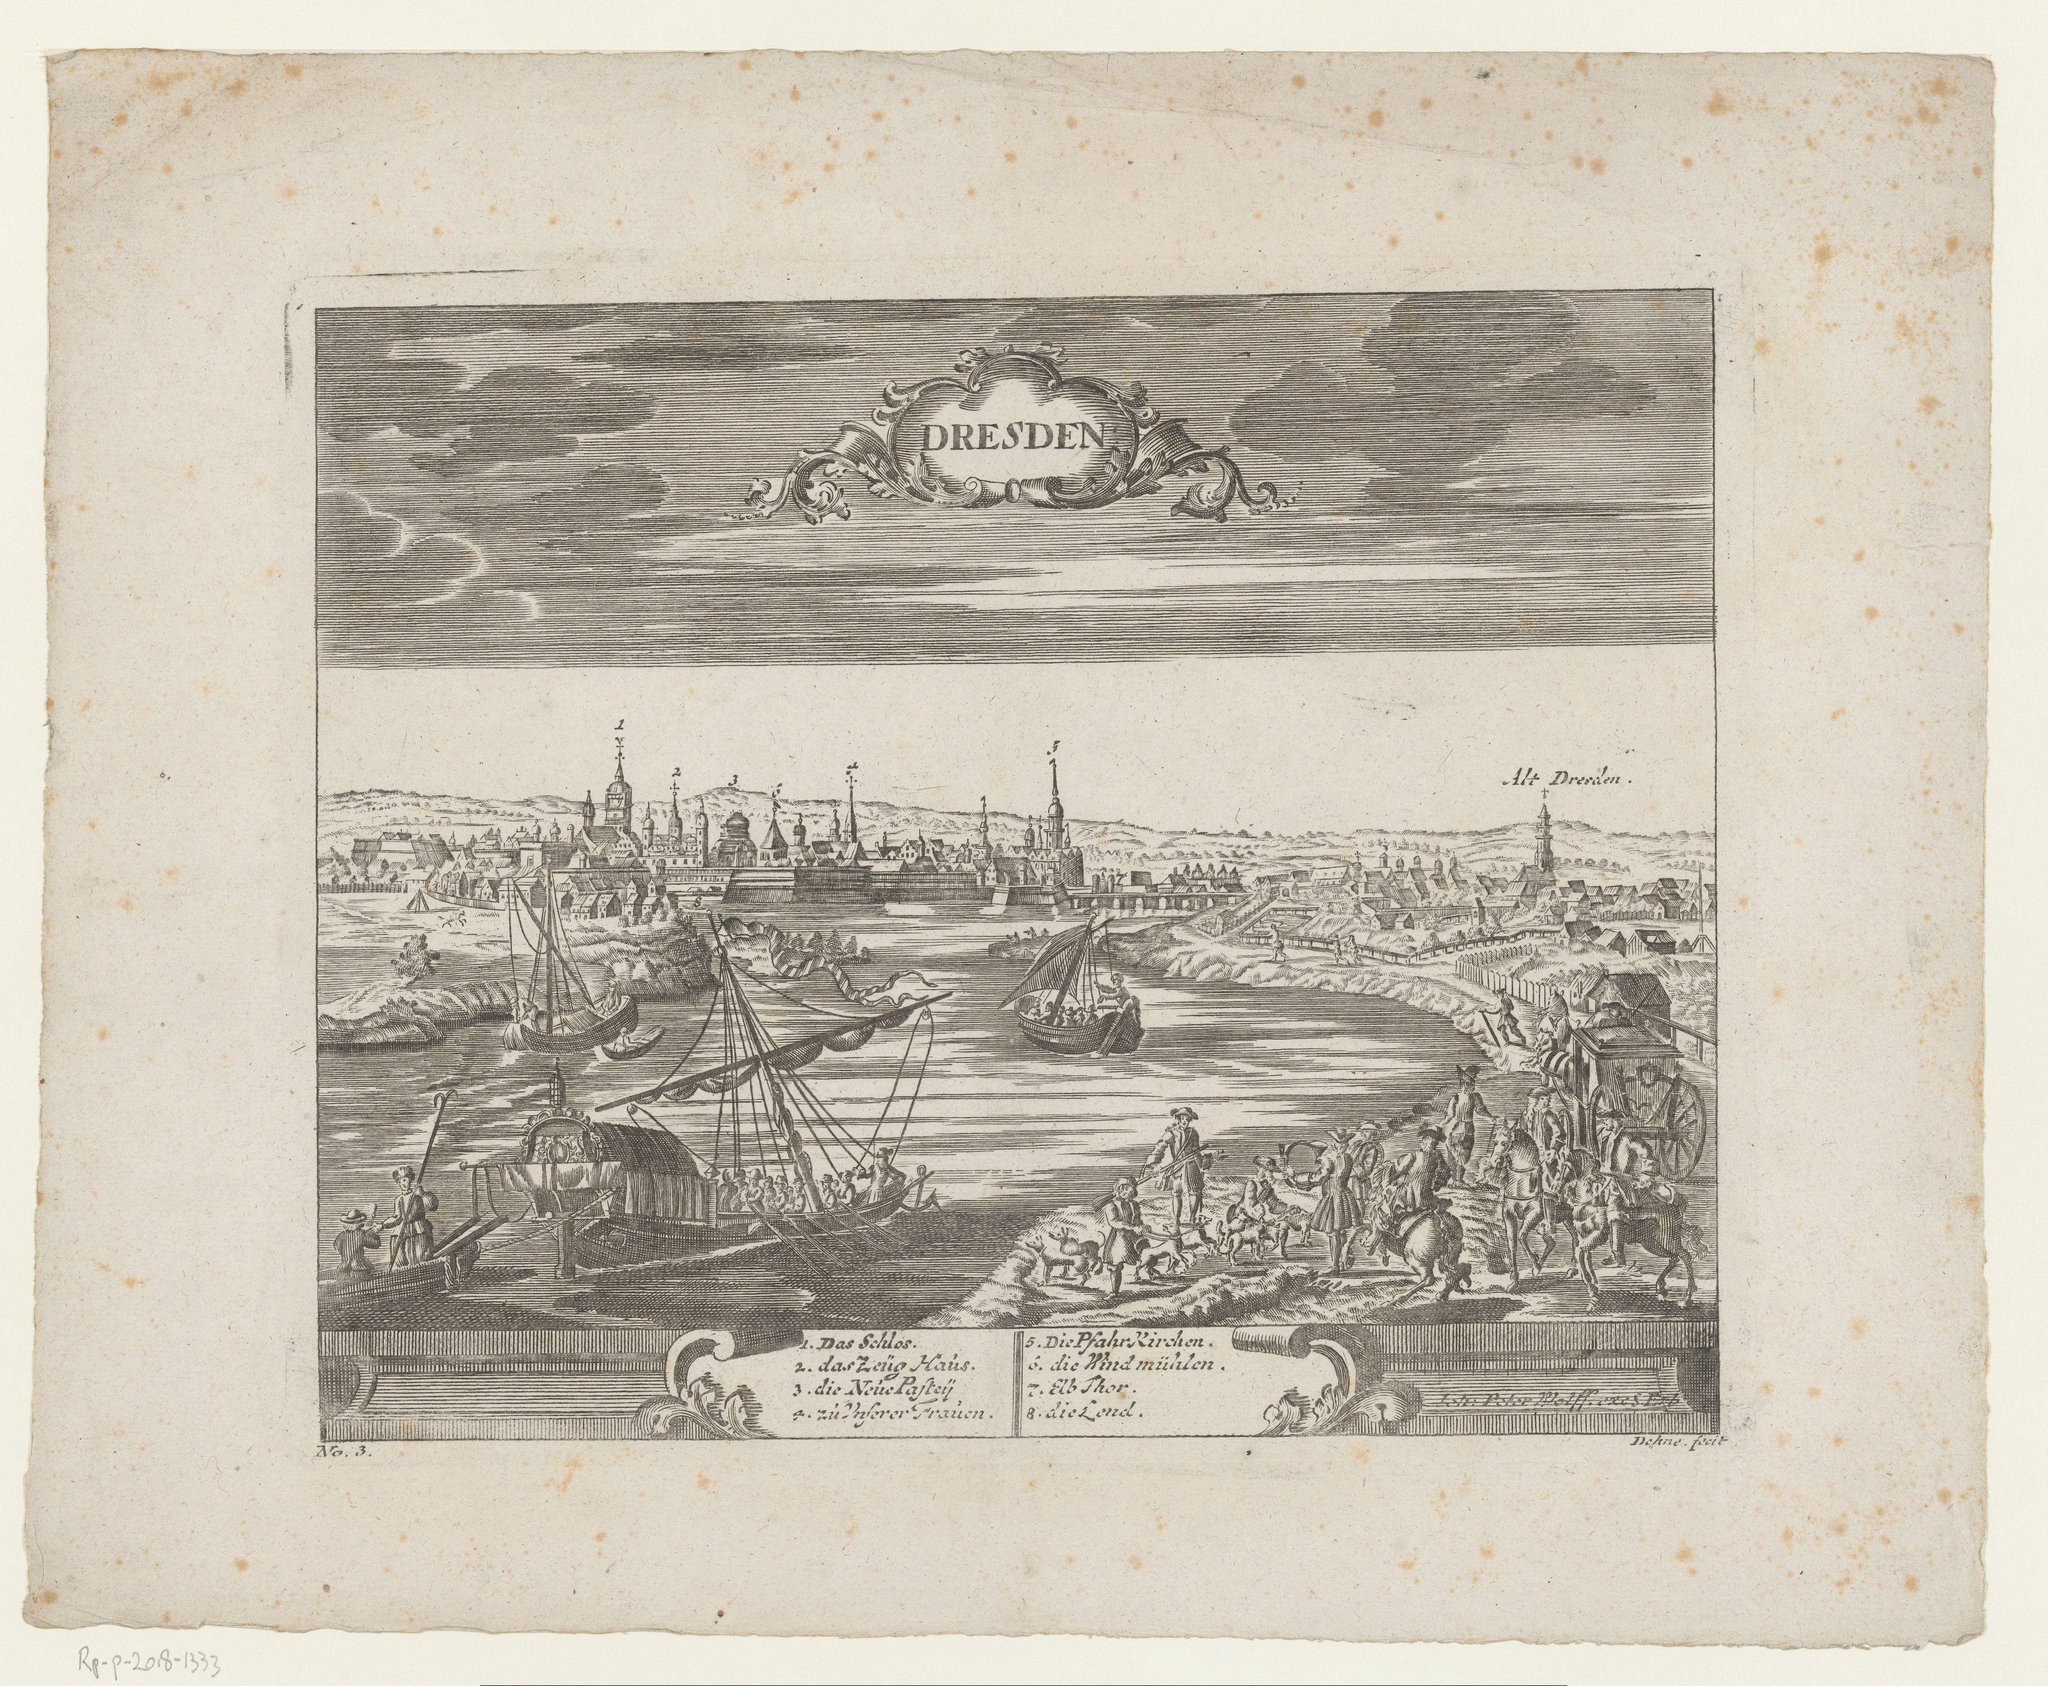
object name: print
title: Gezicht op Dresden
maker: johann christoph dehne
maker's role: print maker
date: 1711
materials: paper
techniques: engraving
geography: nuremberg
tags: rowing-boat, canoe, etc., prospect of city, town panorama, silhouette of city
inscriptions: collector's mark: Lugt 2228